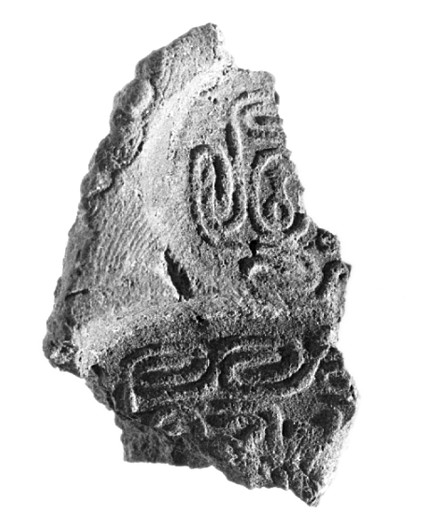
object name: sealing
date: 1981-1640 BCE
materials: mud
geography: egypt